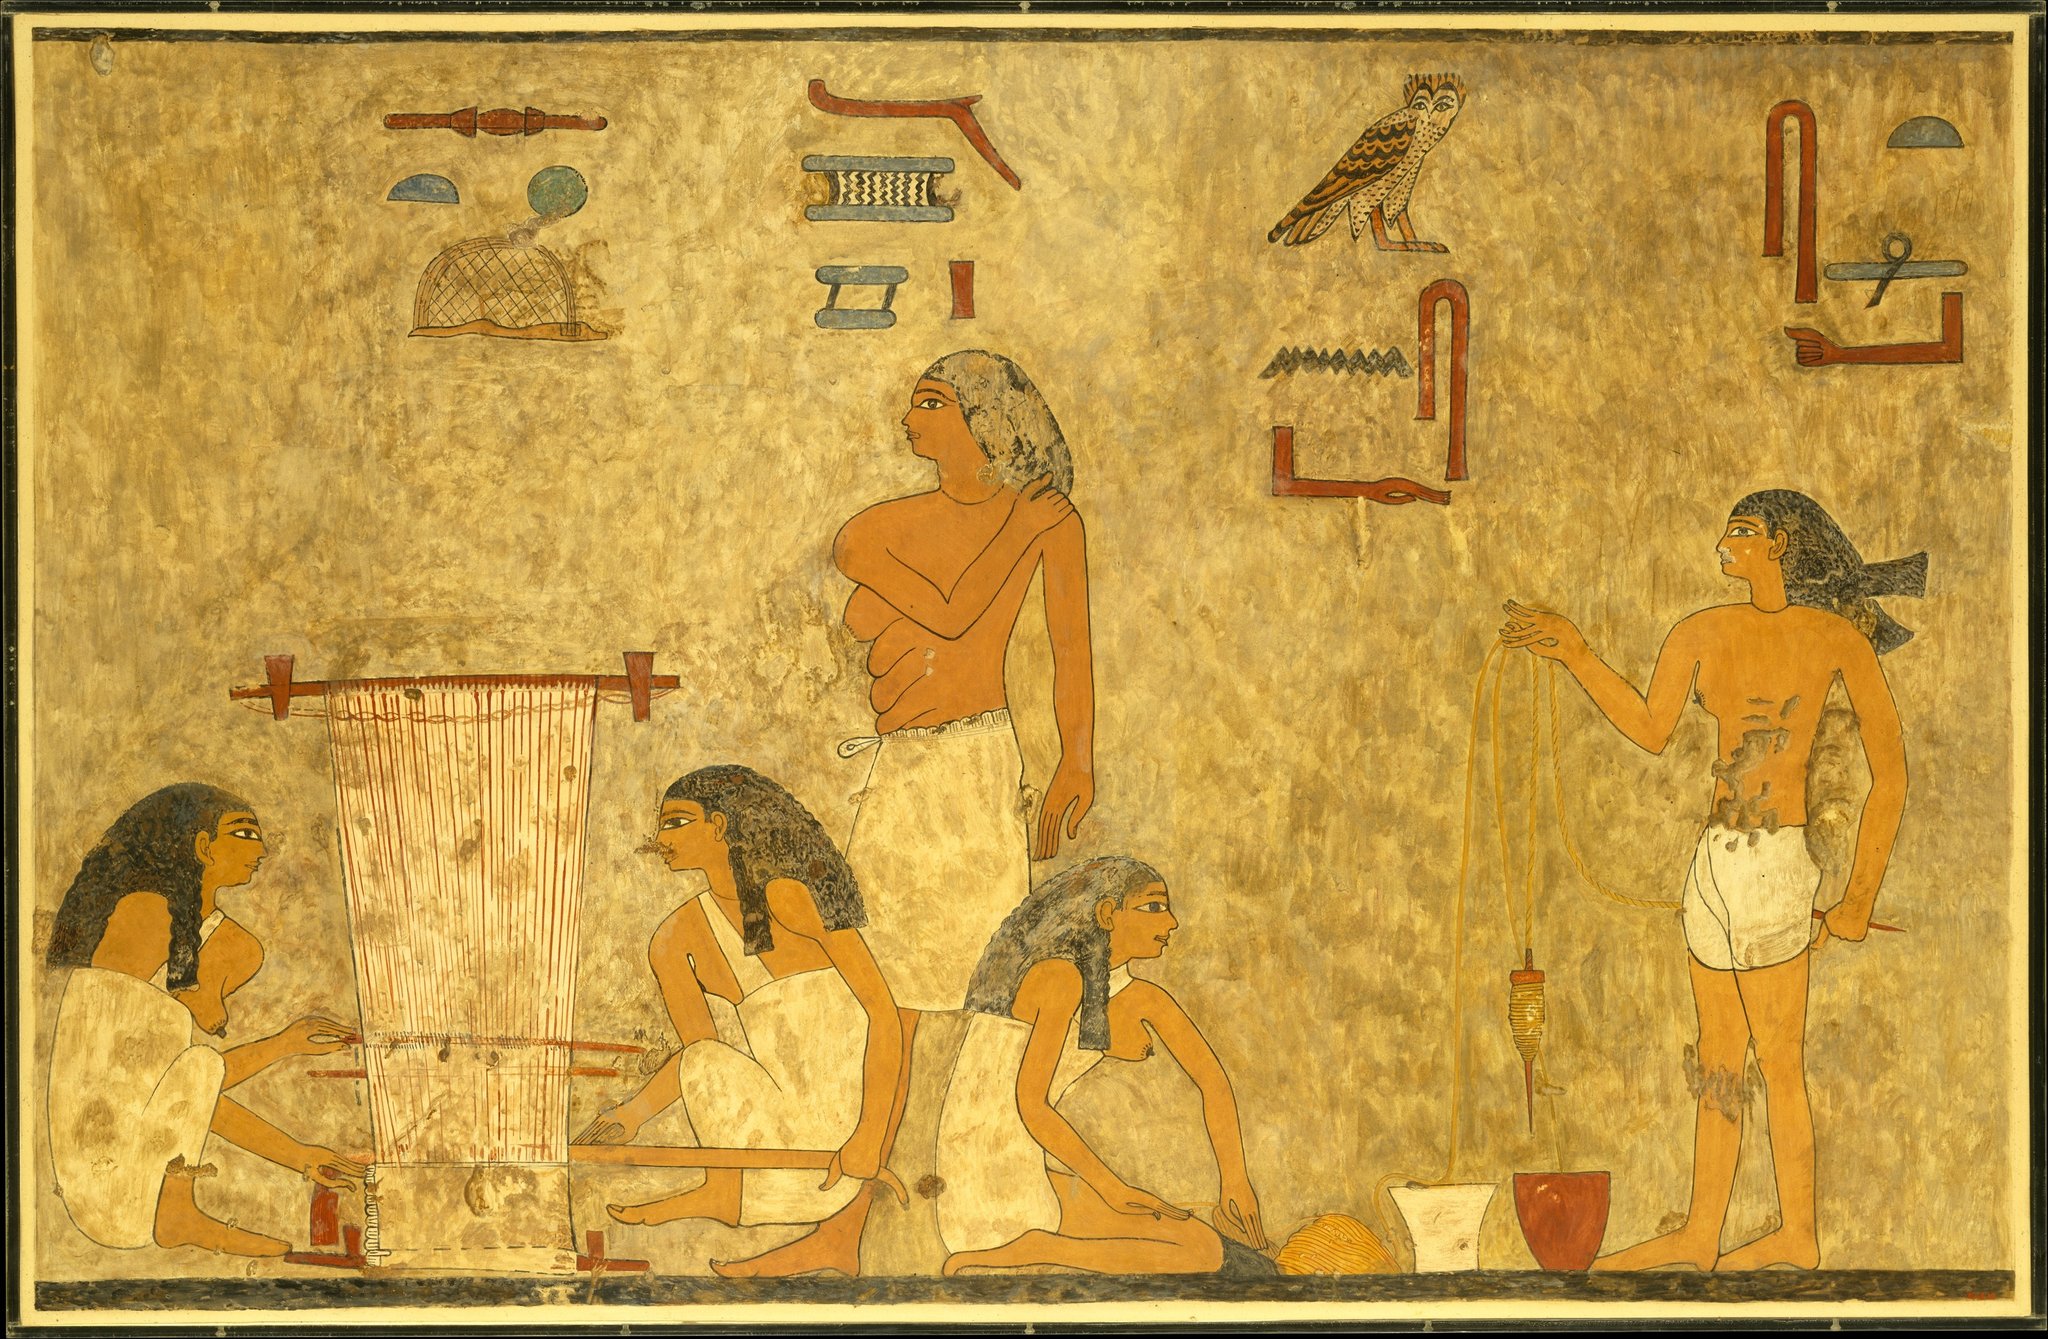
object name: facsimile, khnumhotep beni hasan 3, weaver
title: Weavers, Tomb of Khnumhotep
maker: norman de garis davies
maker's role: artist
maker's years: 1865-1941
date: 1897-1878 BCE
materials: ink, paint, paper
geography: egypt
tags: men,women,hieroglyphs,working